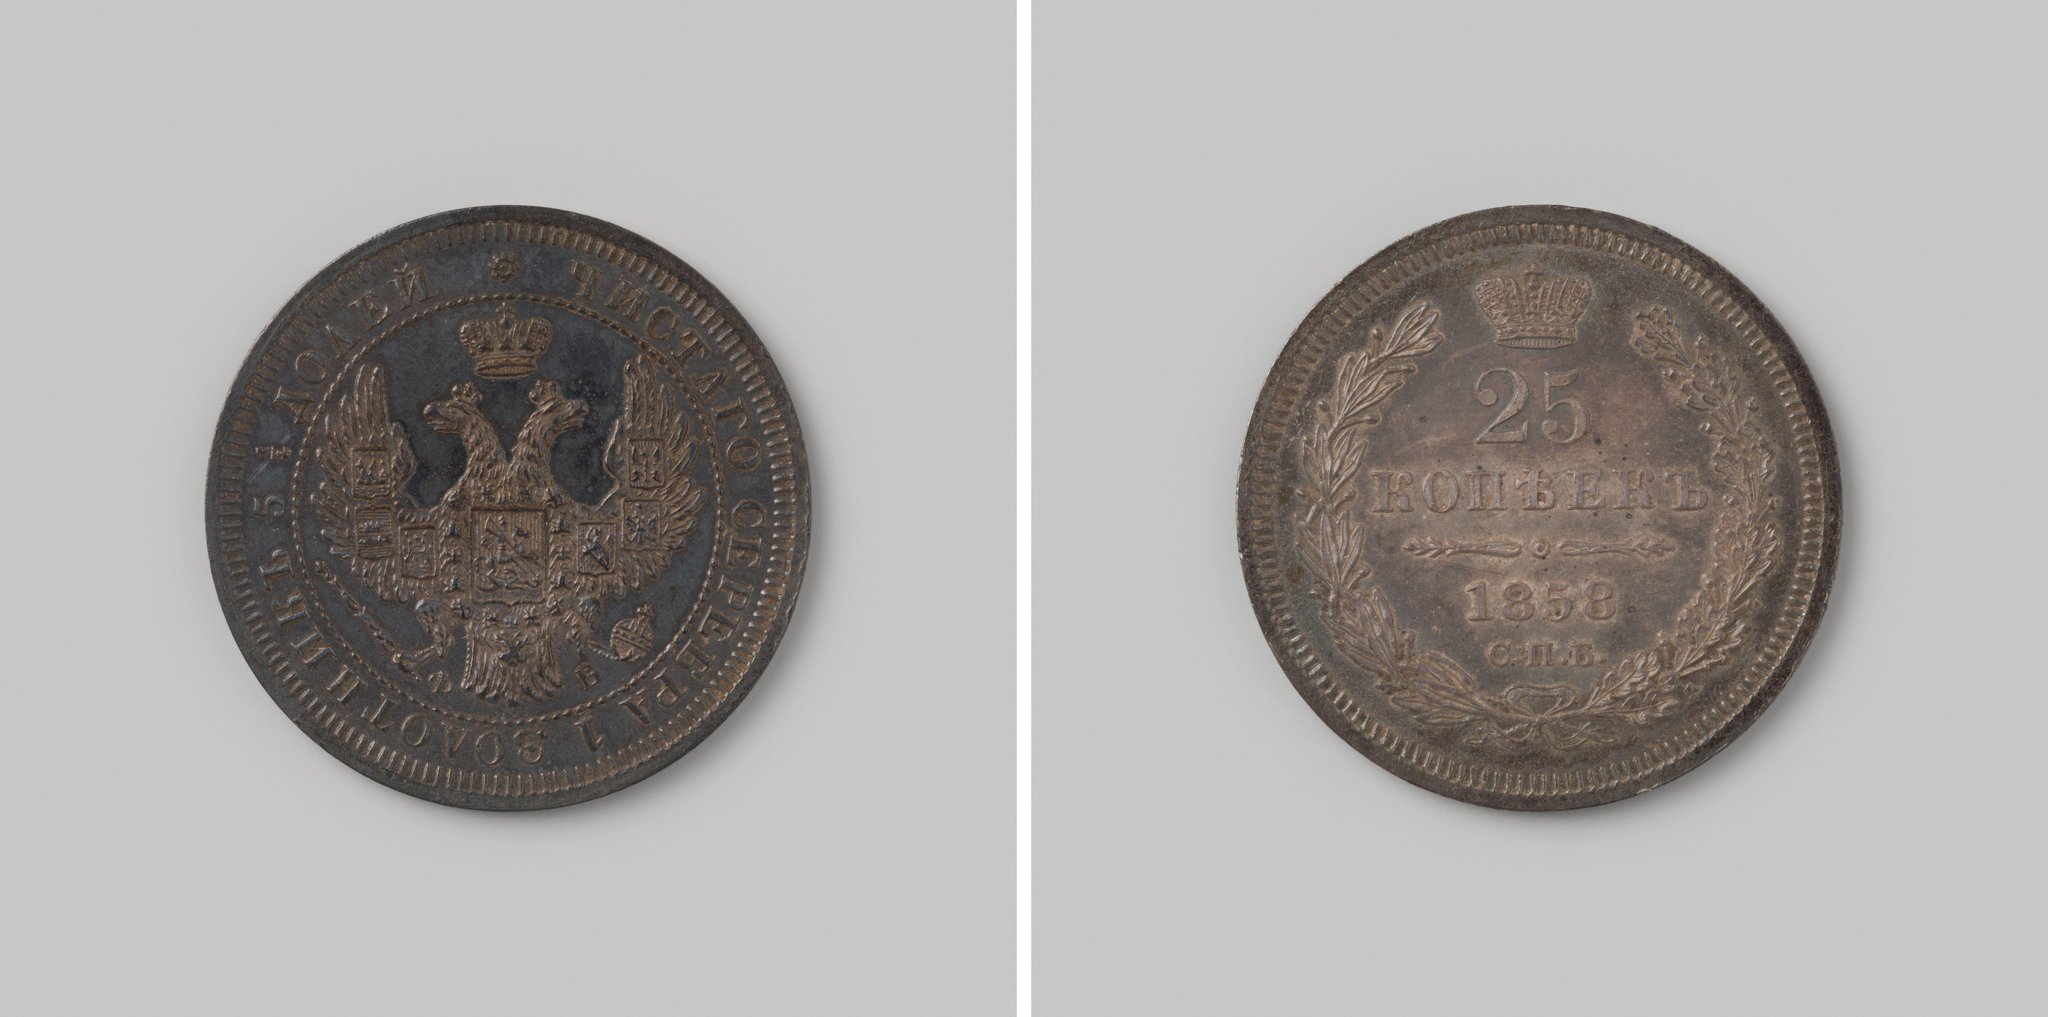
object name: coin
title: 25 kopeken uit Rusland van tsaar Alexander II, 1858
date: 1858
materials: silver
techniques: striking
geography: sint-petersburg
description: Zilveren munt. Voorzijde: dubbelkoppige gekroonde adelaar met gespreide vleugels en met op zijn vleugels kleine wapenschilden en op zijn borst een groot, met een ridderorde omhangen wapenschild en in zijn poten een scepter en een gekroonde bol. Boven de adelaar een kroon met lint. Keerzijde: tussen twee samengebonden takken een kroon, waaaronder in twee regels de waarde-aanduiding. Daaronder jaartal, waaronder in het Cyrillisch de letters S,P en B [=Sint Petersburg]. Kabelrand.